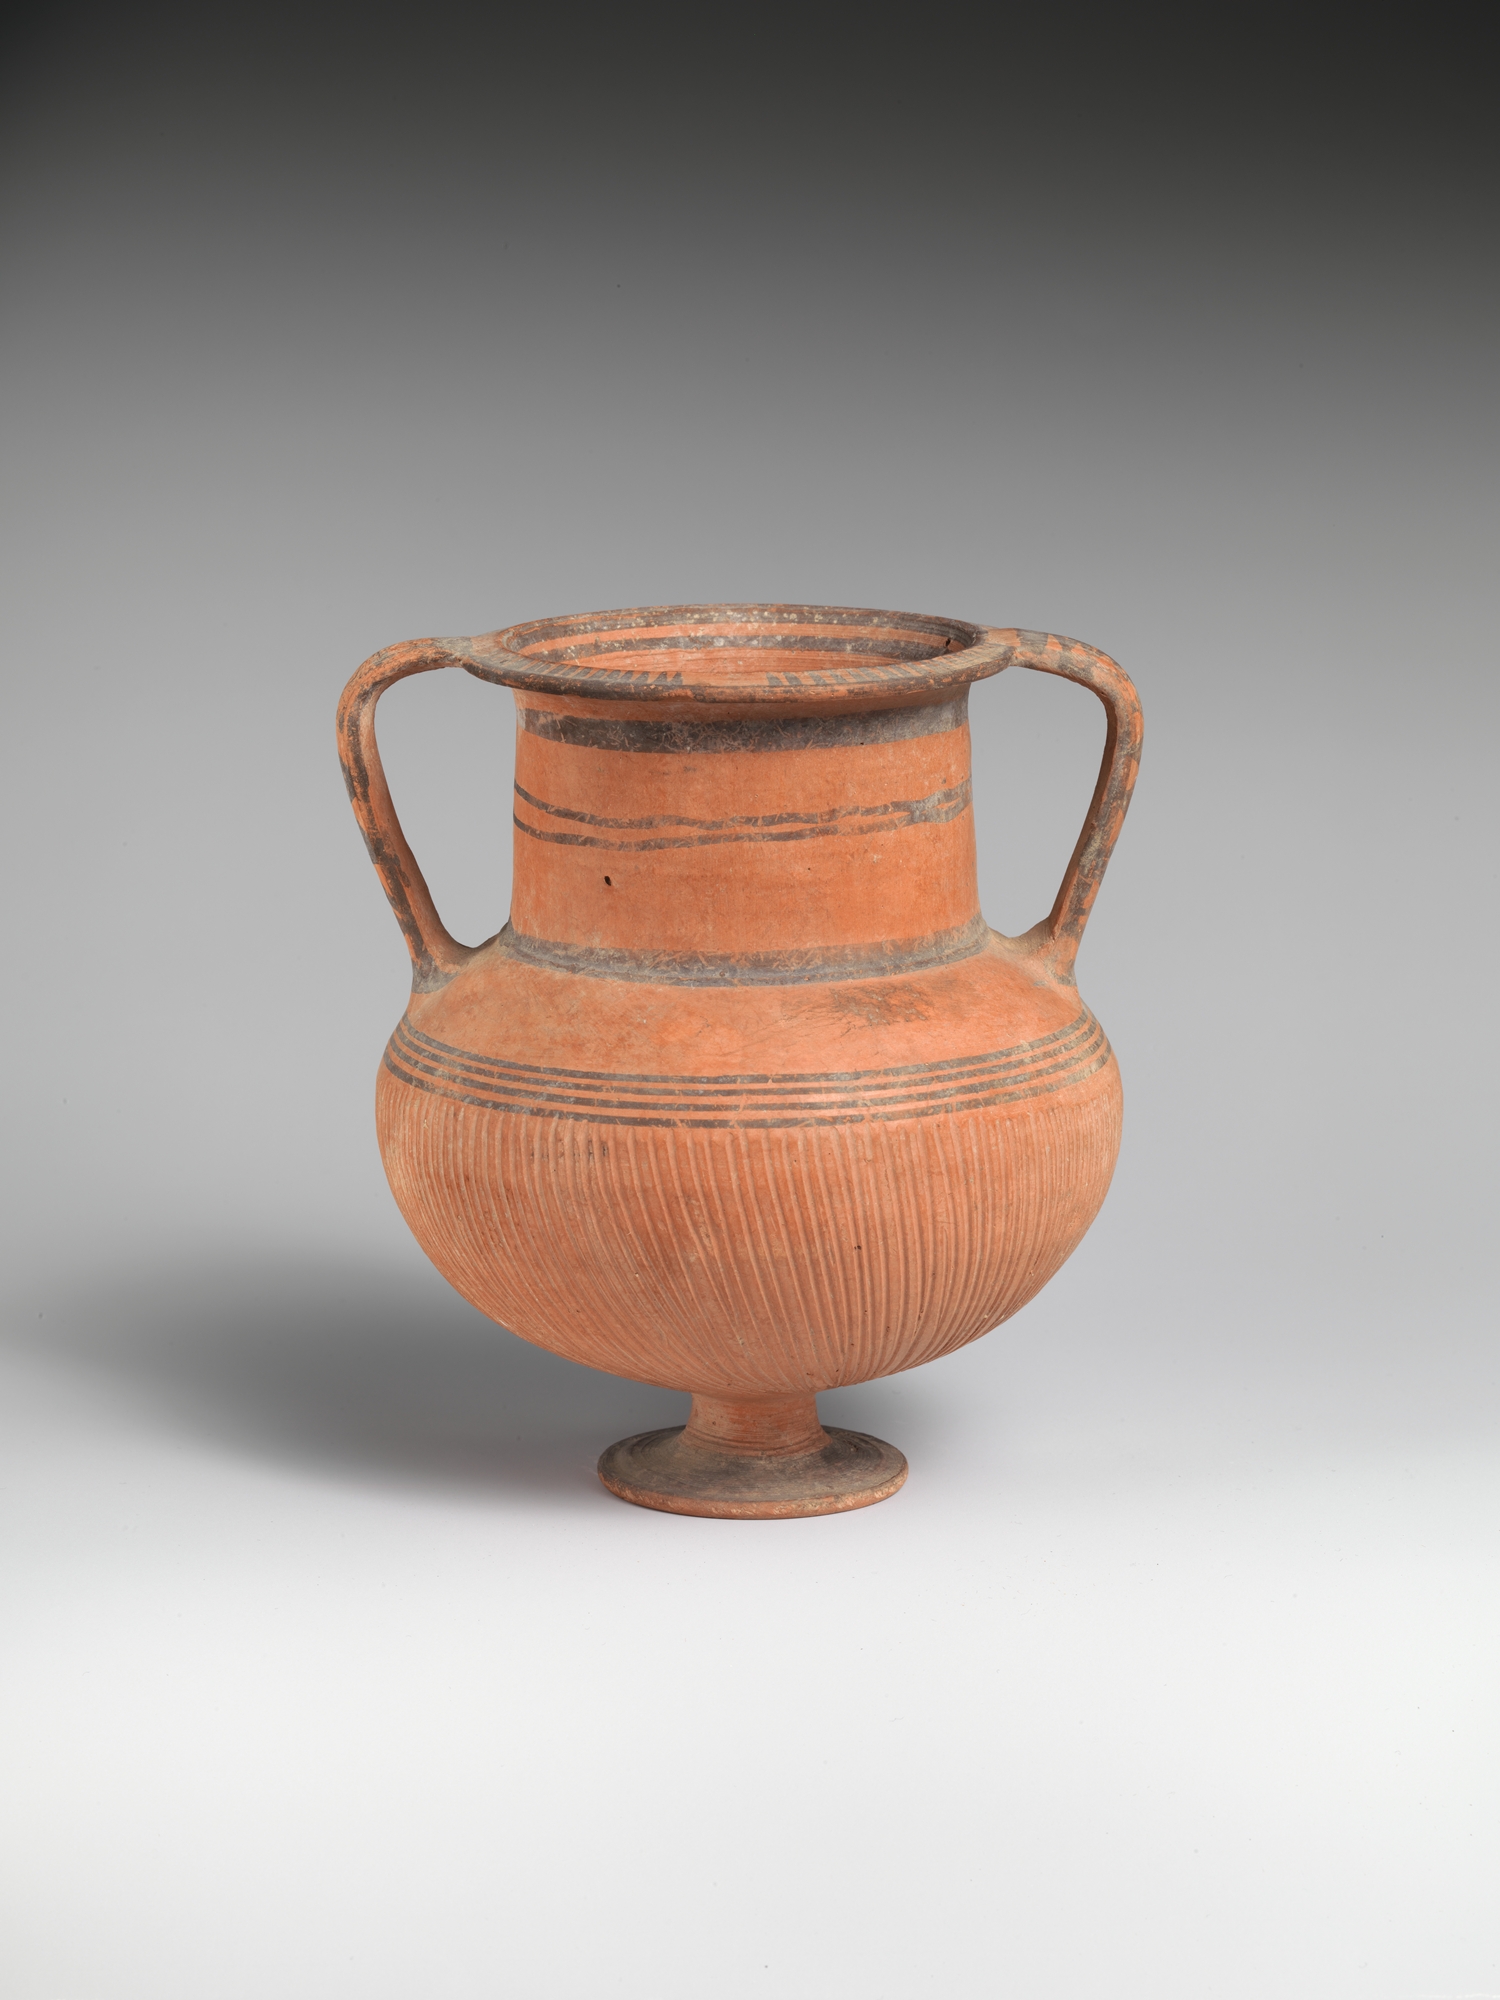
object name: amphoriskos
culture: cypriot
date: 850-750 BCE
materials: terracotta